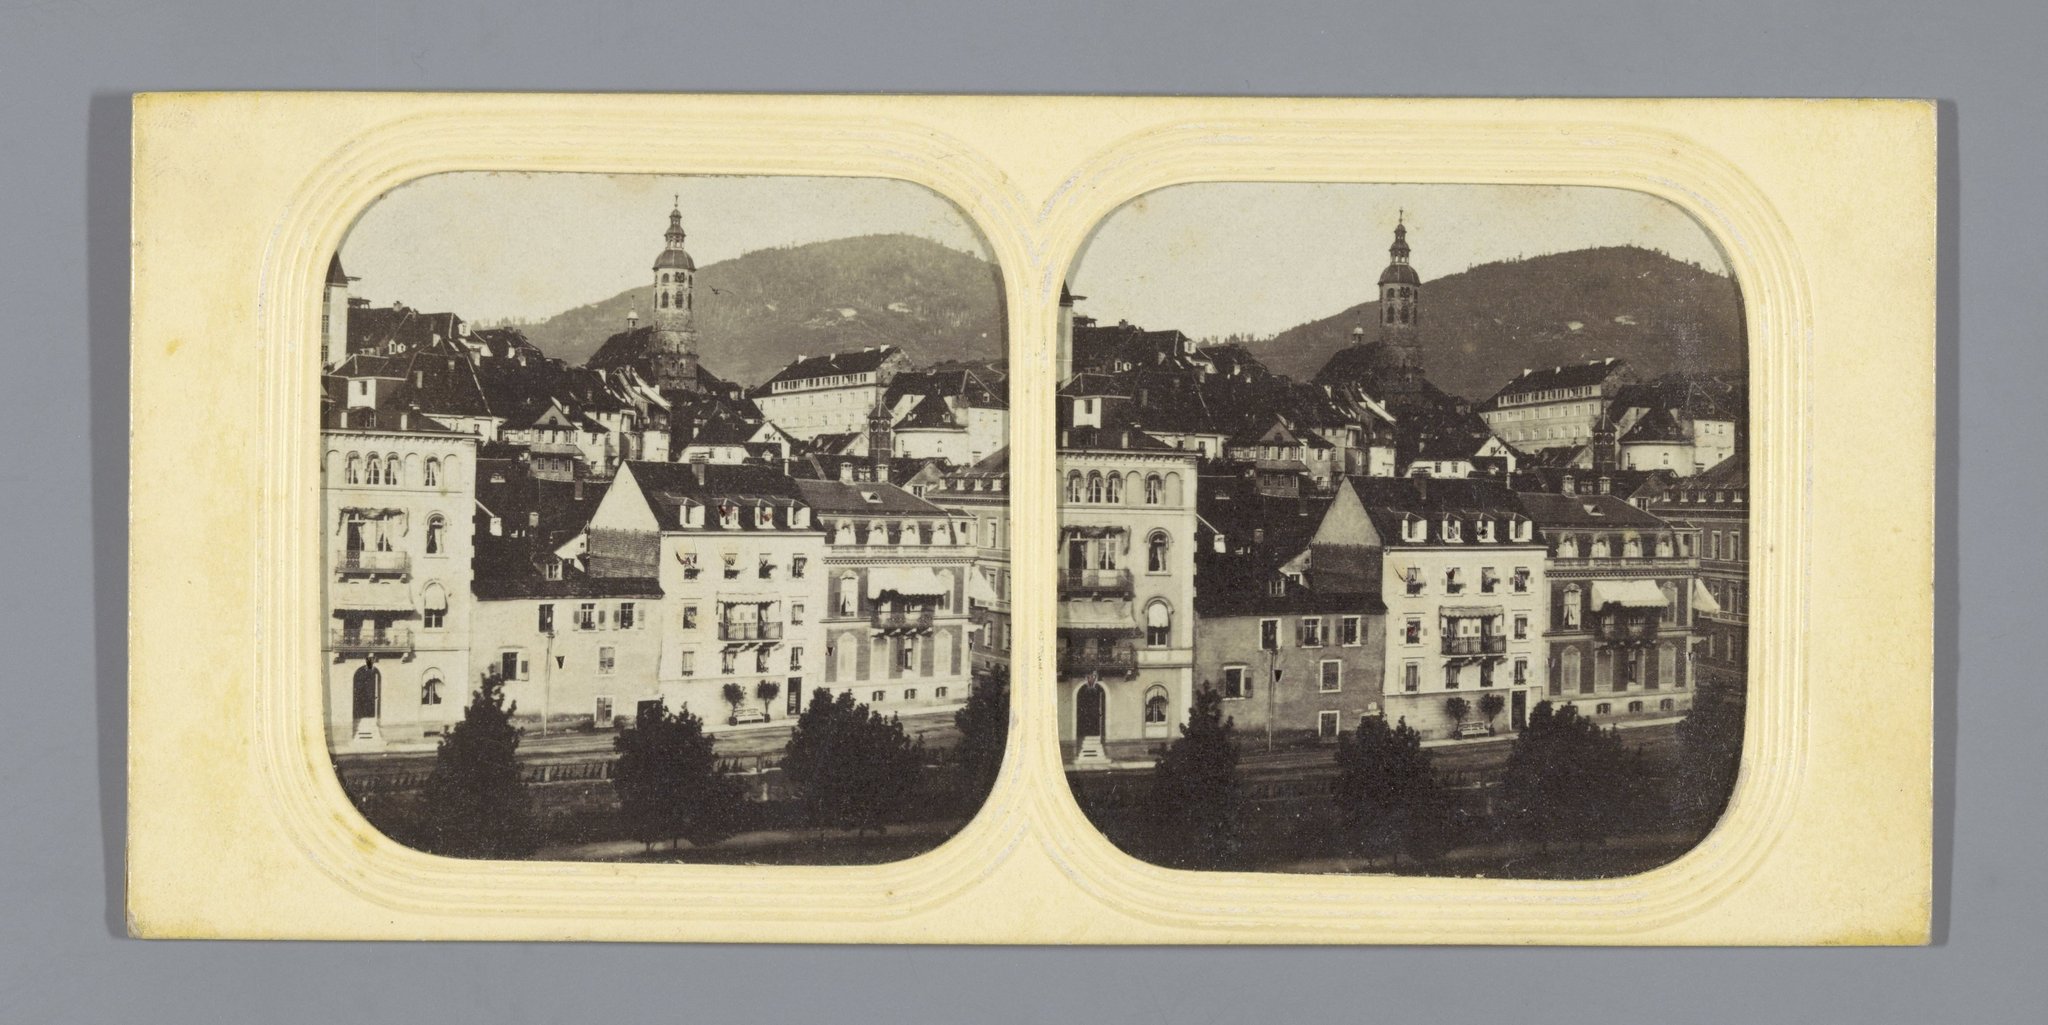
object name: tissue stereograph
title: Bade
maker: Anonymous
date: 1855-1875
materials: cardboard, paper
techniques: albumen print, cutting, hand coloring, perforating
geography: baden-baden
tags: city-view in general; 'veduta'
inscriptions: inscription: ‘1875/ No. 22/ Vr./ 24 Sept/ Juli 1885’